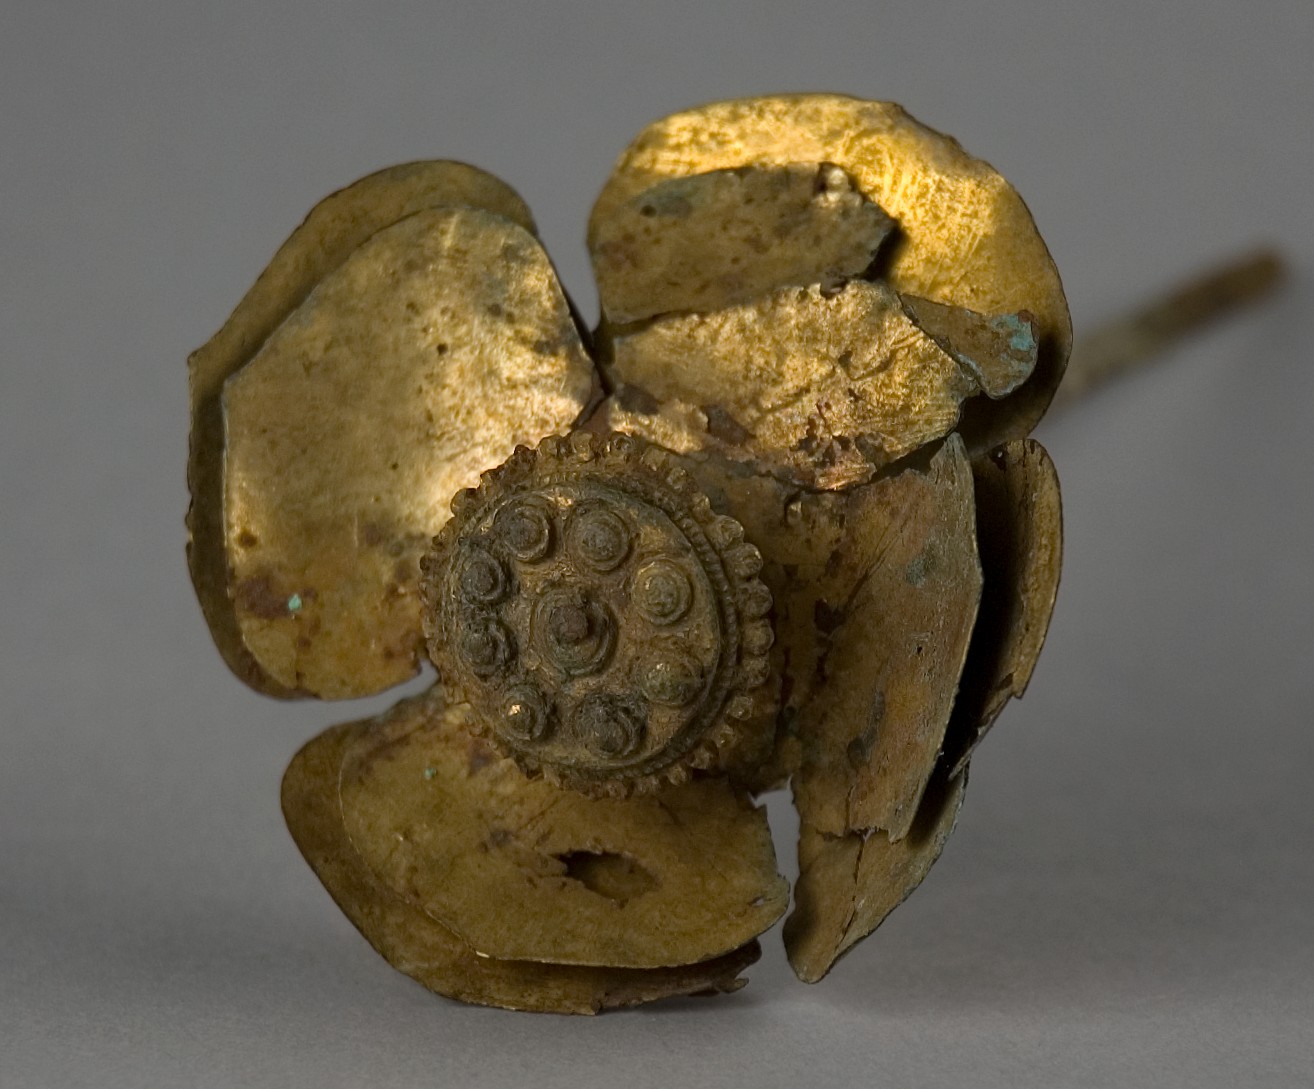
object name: ornament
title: Ornament in the Shape of a Lotus Flower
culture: cambodian or thai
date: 1101-1200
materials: bronze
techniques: gilding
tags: lotuses